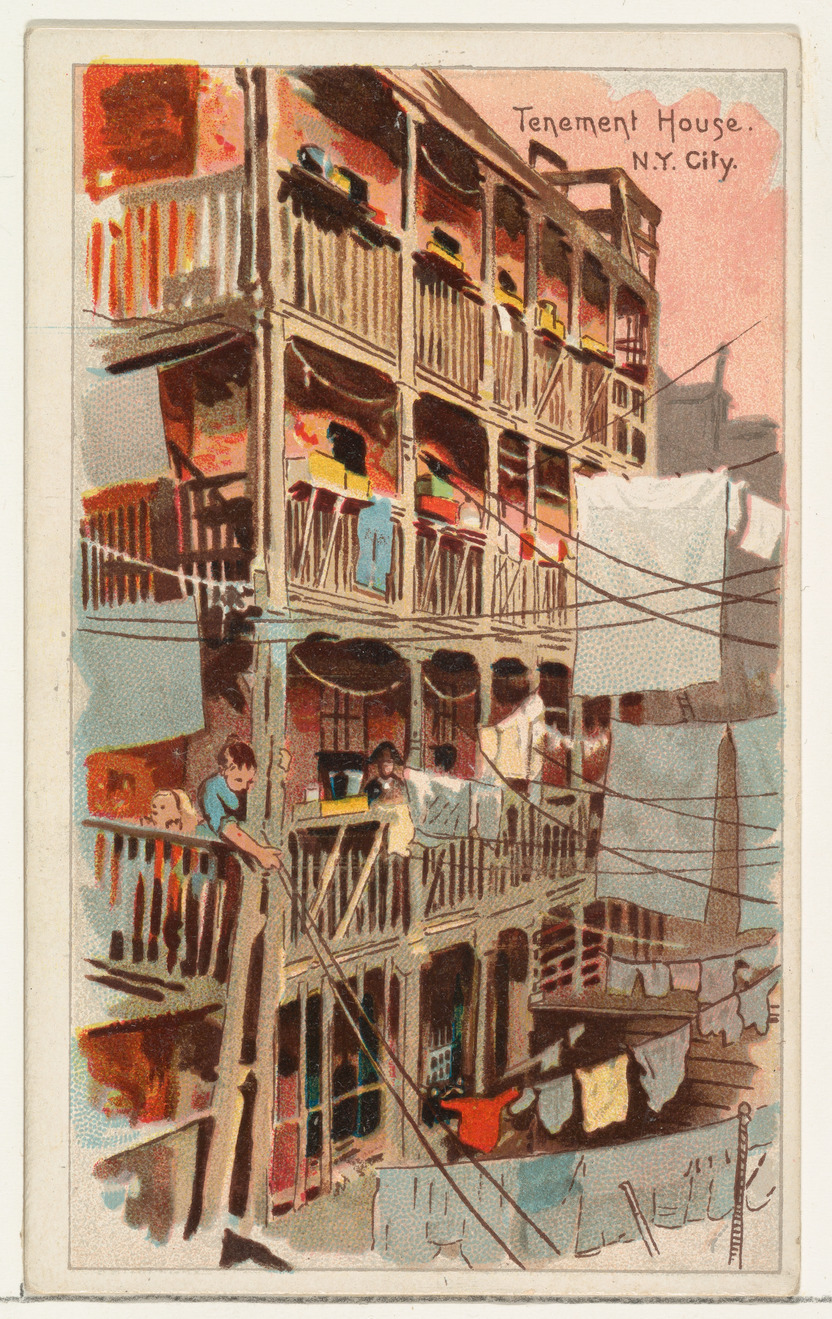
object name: print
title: Tenement House, New York City, from the Habitations of Man series (N113) issued by W. Duke, Sons & Co. to promote Honest Long Cut Smoking and Chewing Tobacco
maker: the giles company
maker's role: artist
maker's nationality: american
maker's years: 1800-1900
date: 1890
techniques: color lithograph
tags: new york city